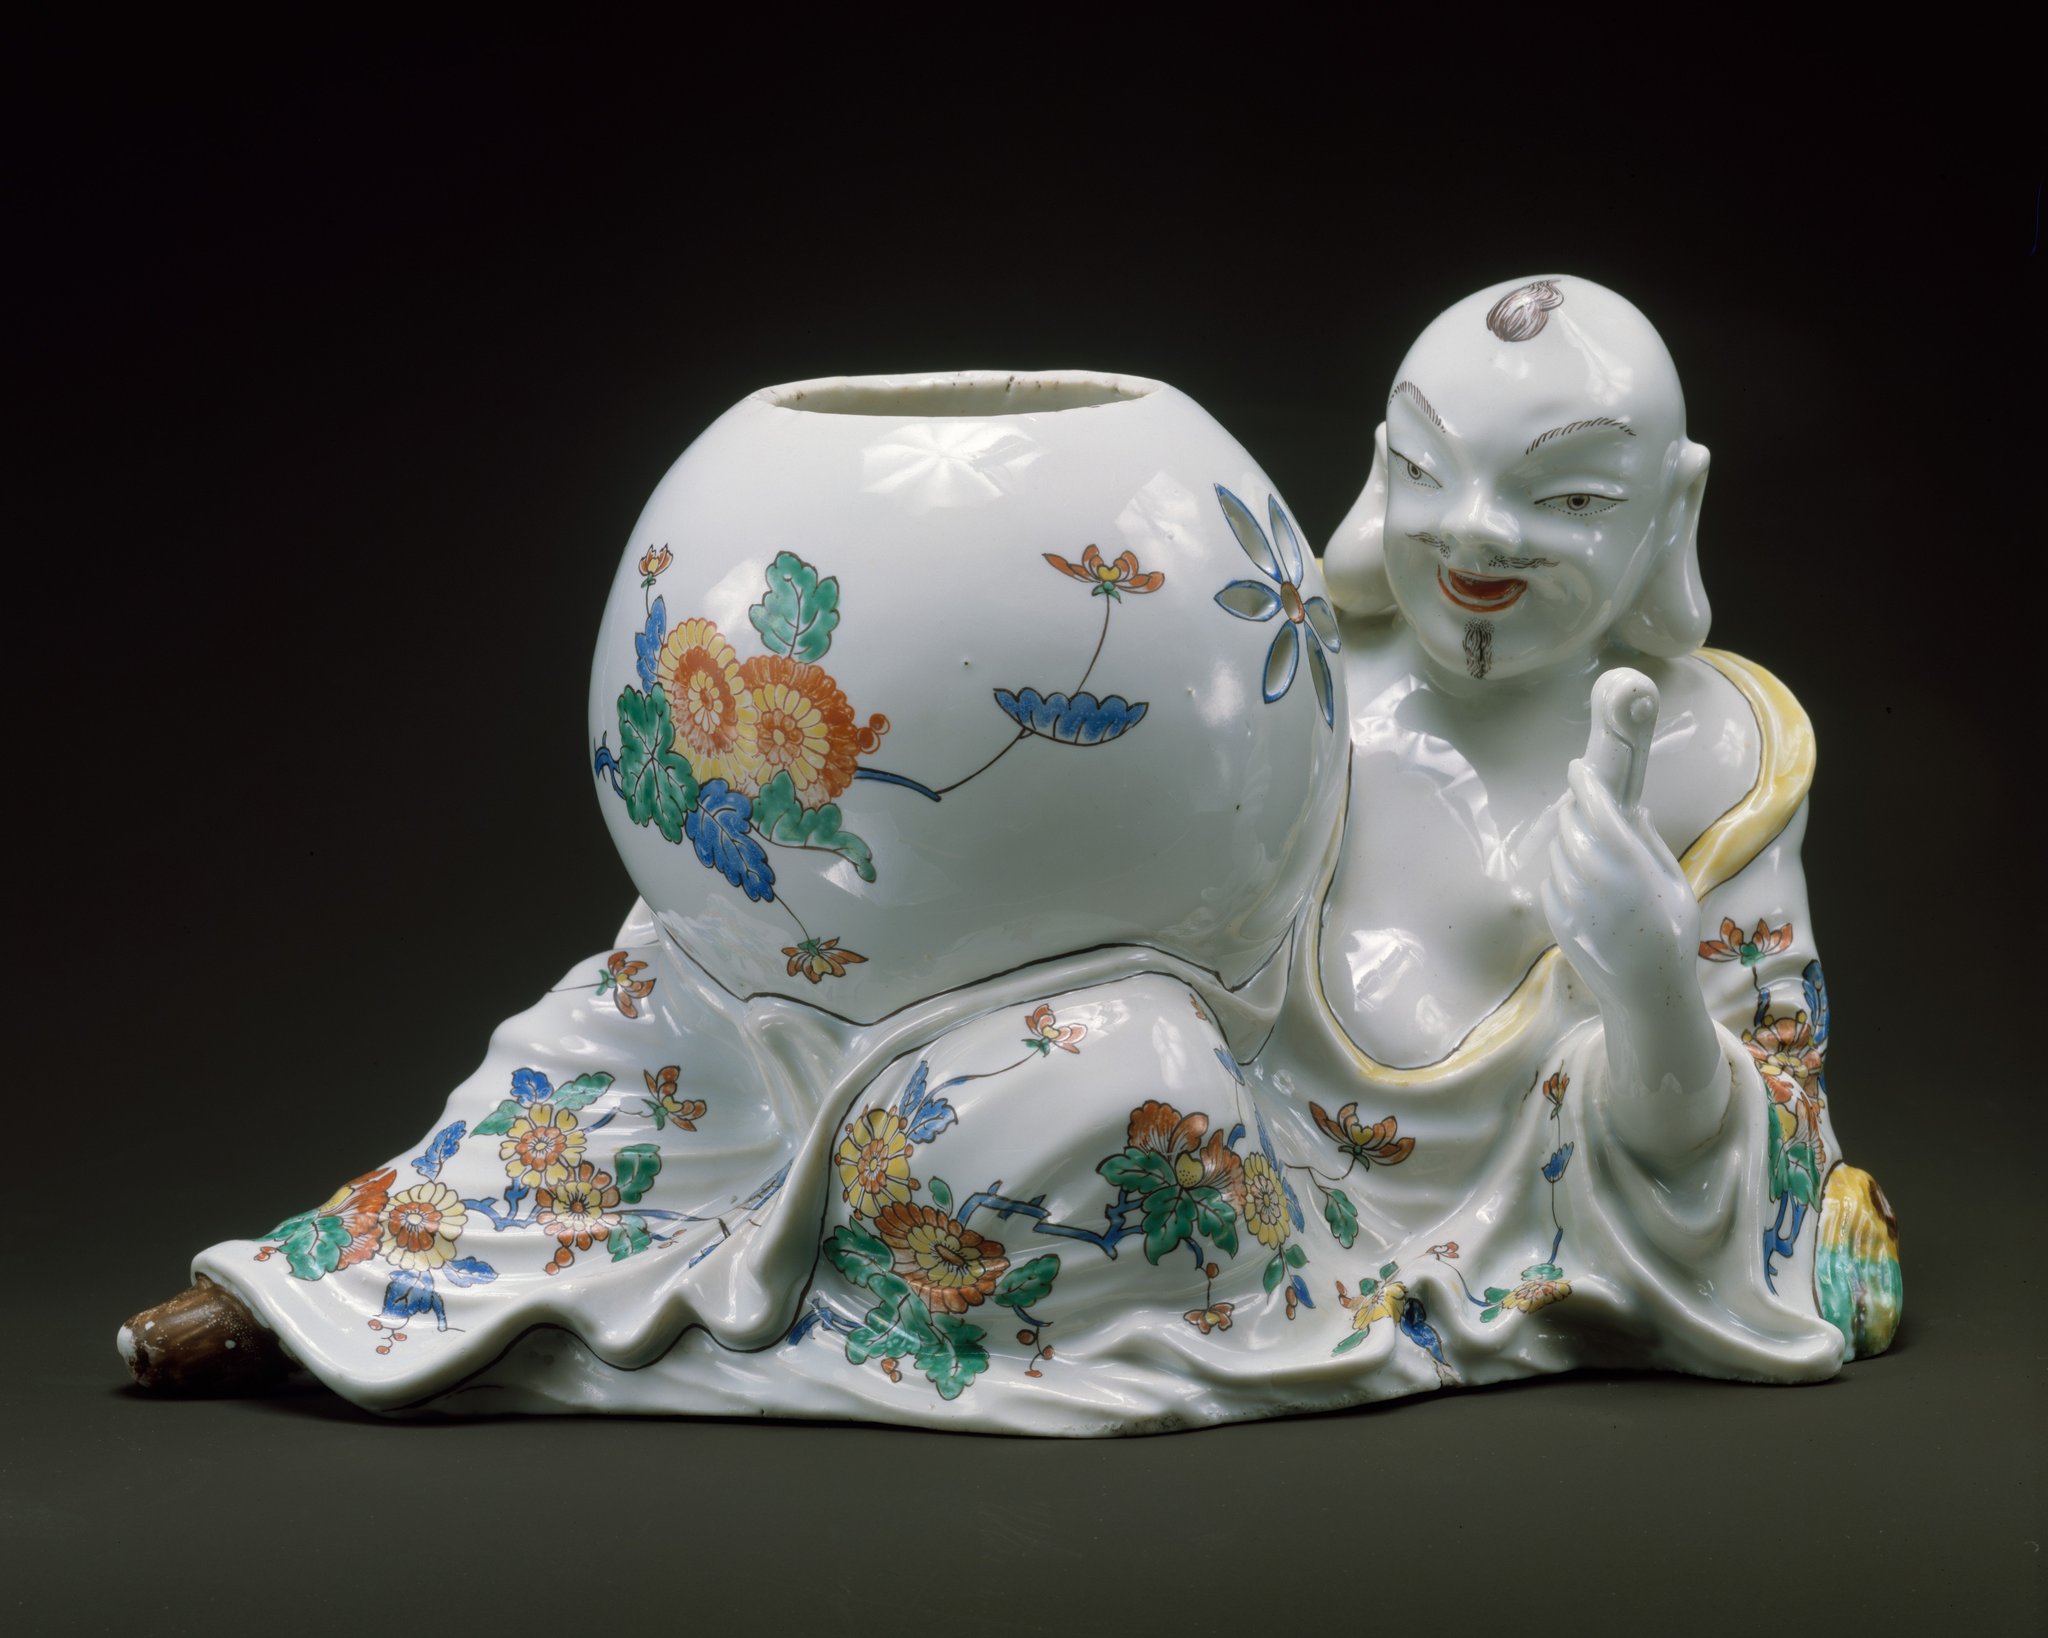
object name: potpourri jar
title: Oriental with Potpourri Jar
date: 1735-1740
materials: soft paste porcelain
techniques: glazing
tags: men